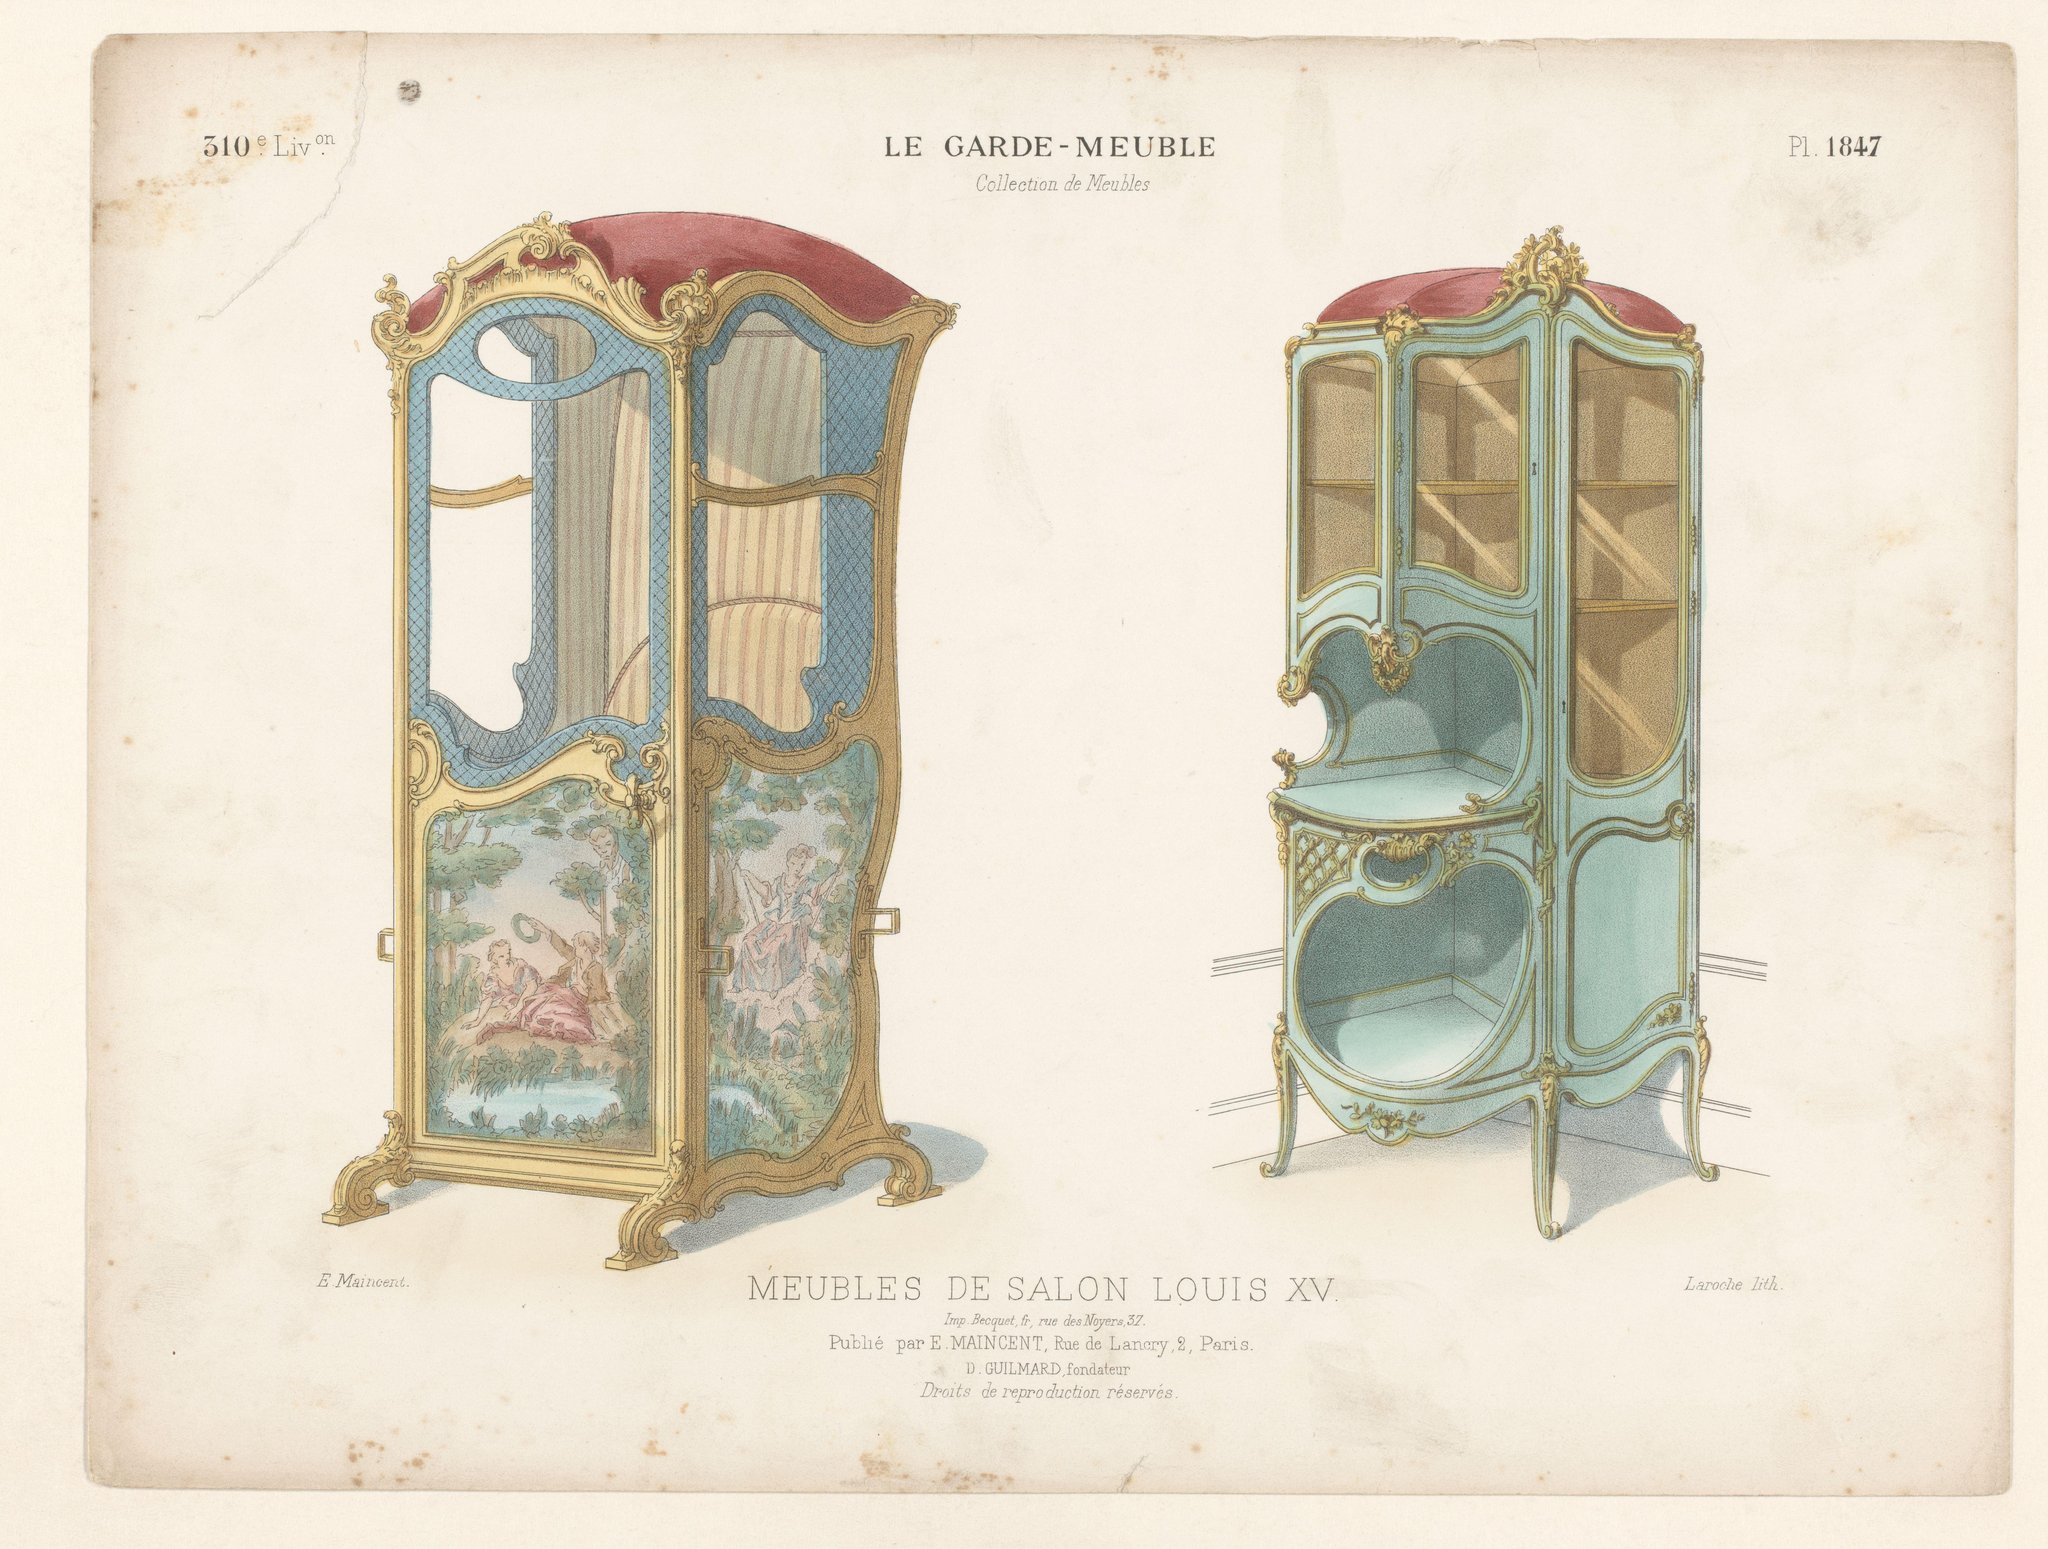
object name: print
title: Meubles de salon Louis XV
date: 1885-1895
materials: paper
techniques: hand coloring, lithograph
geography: paris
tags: furniture for storage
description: Ieder Livraison in de serie Le Garde-Meuble bevat negen platen: drie 'sièges' (zitmeubels), drie 'meubles' (diverse meubels zoals tafels en kasten) en drie 'tentures' (gordijnen en draperieën).